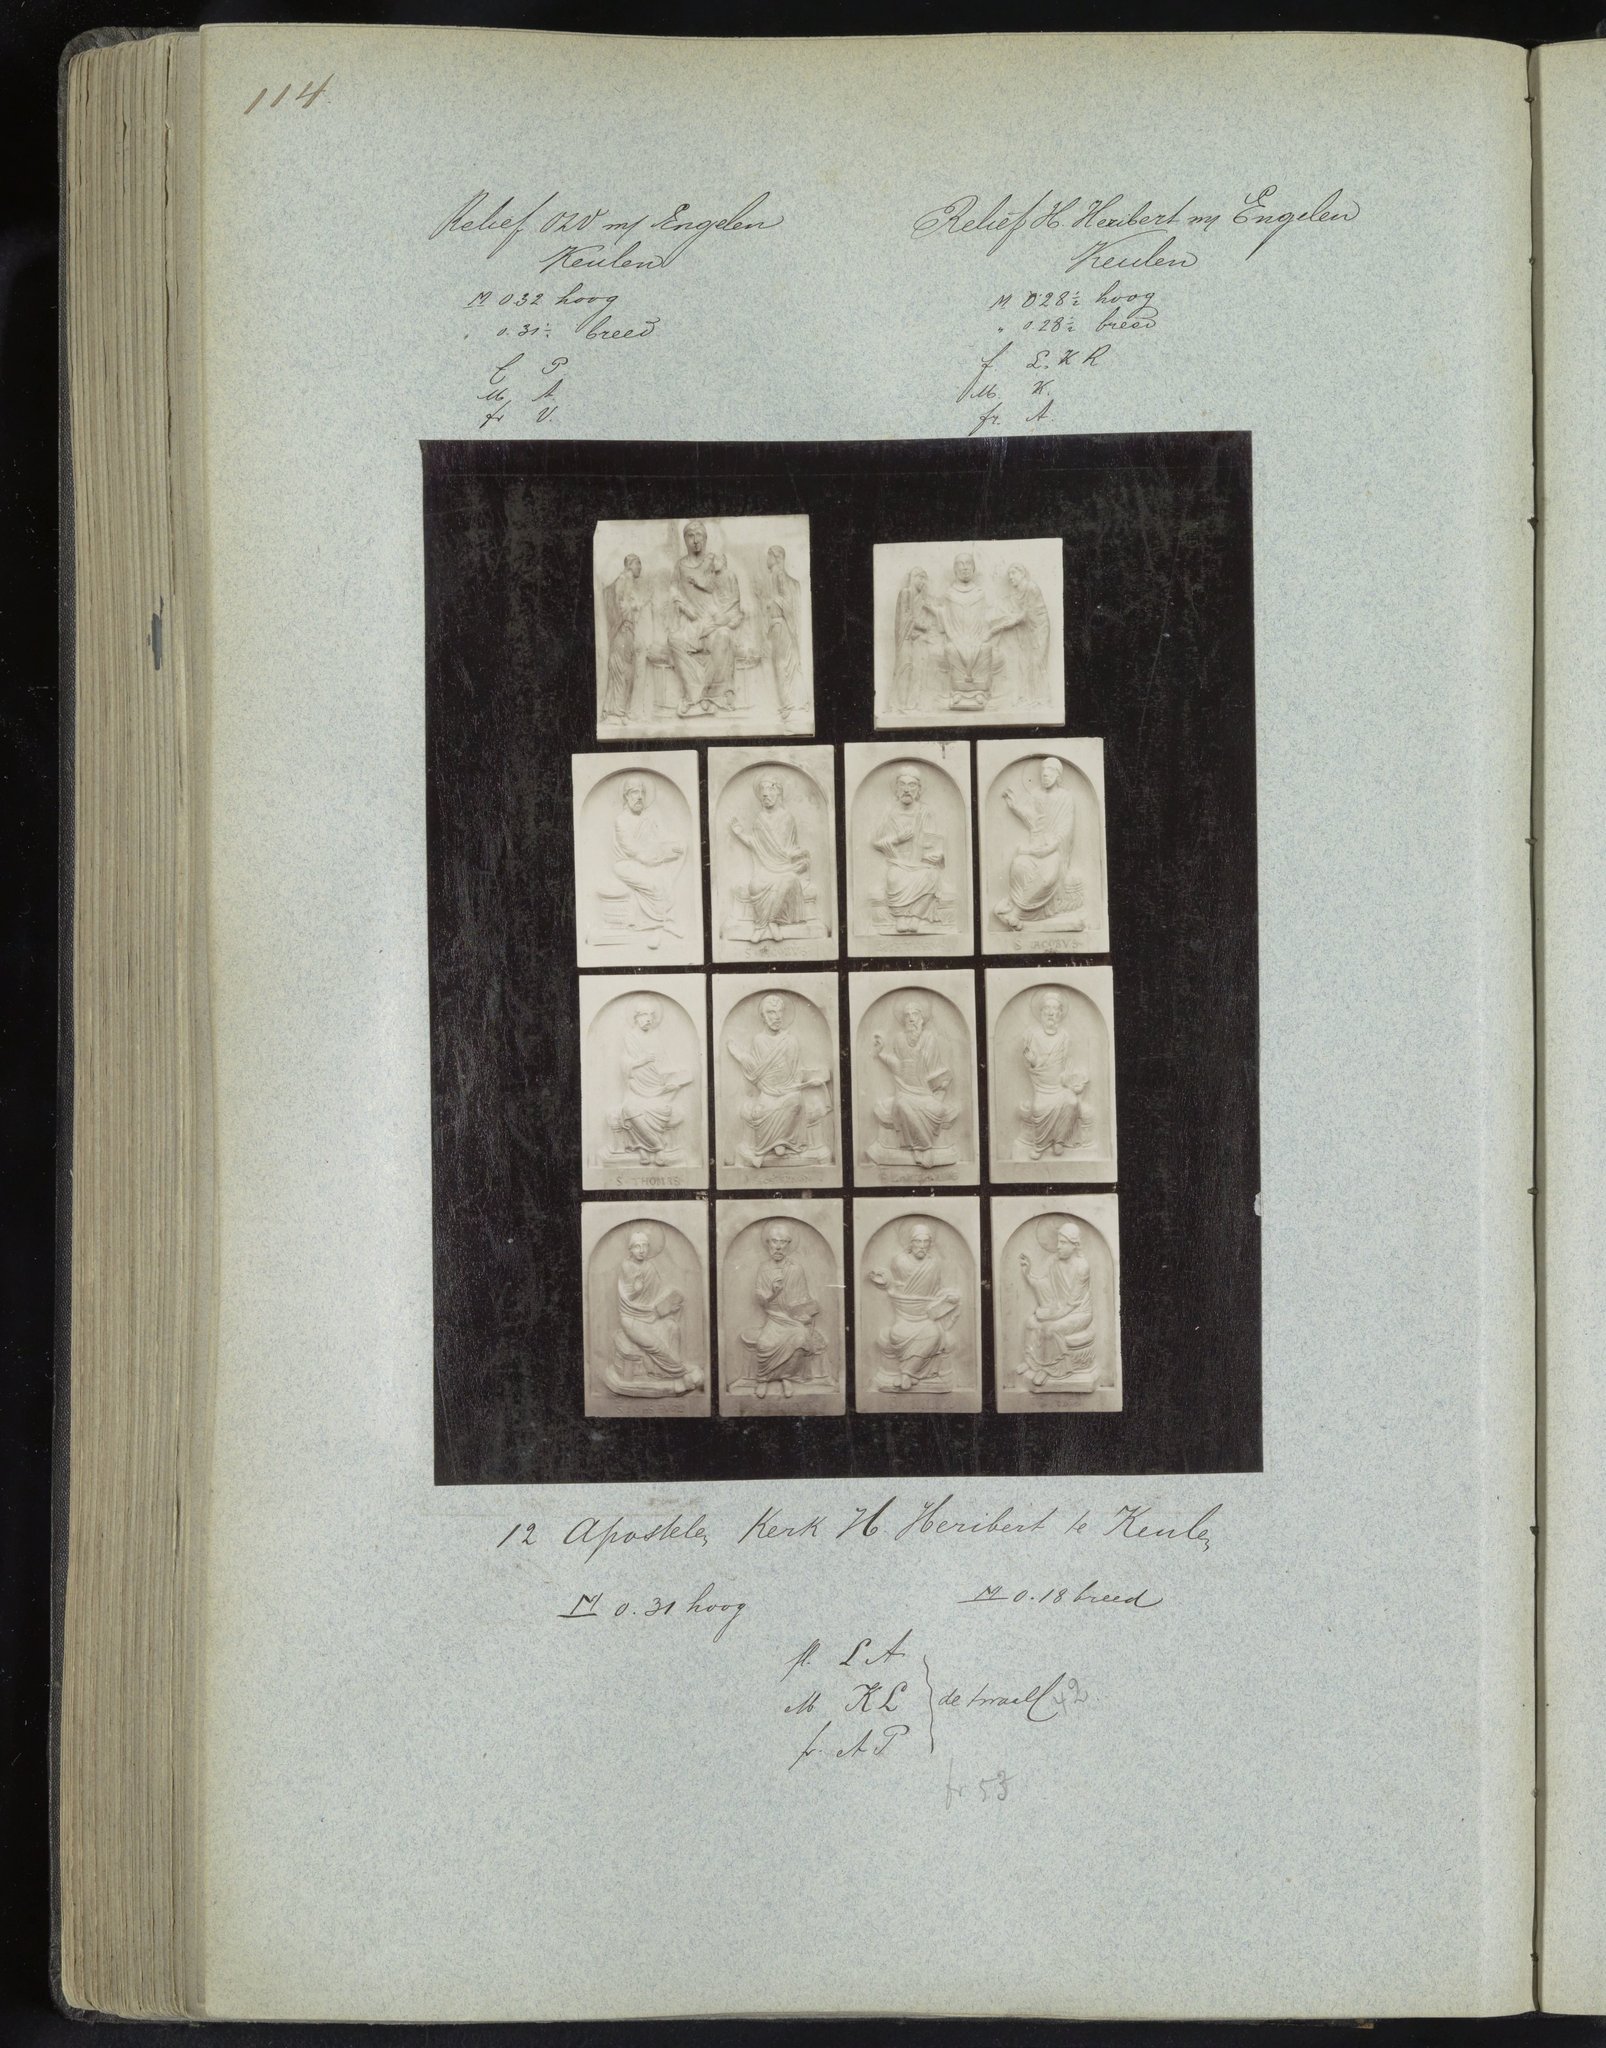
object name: album leaf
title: Twaalf gipsen afgietsels van panelen van de twaalf apostelen en twee afgietsels van reliëfs van engelen, uit de Sint Heribert te Keulen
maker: Anonymous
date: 1875-1900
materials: paper, photographic support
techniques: albumen print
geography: cologne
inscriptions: annotation, annotation: ‘Reliëf [...] Engelen Keulen / M 0.32 hoog / 0.31 breed’, annotation: ‘Reliëf St. Heribert [...] Engelen / Keulen / M 0.28 1/2 hoog / 0.28 1/2 breed’, annotation: ‘12 Apostelen Kerk St. Heribert te Keulen / M 0.31 hoog M 0.18 breed’